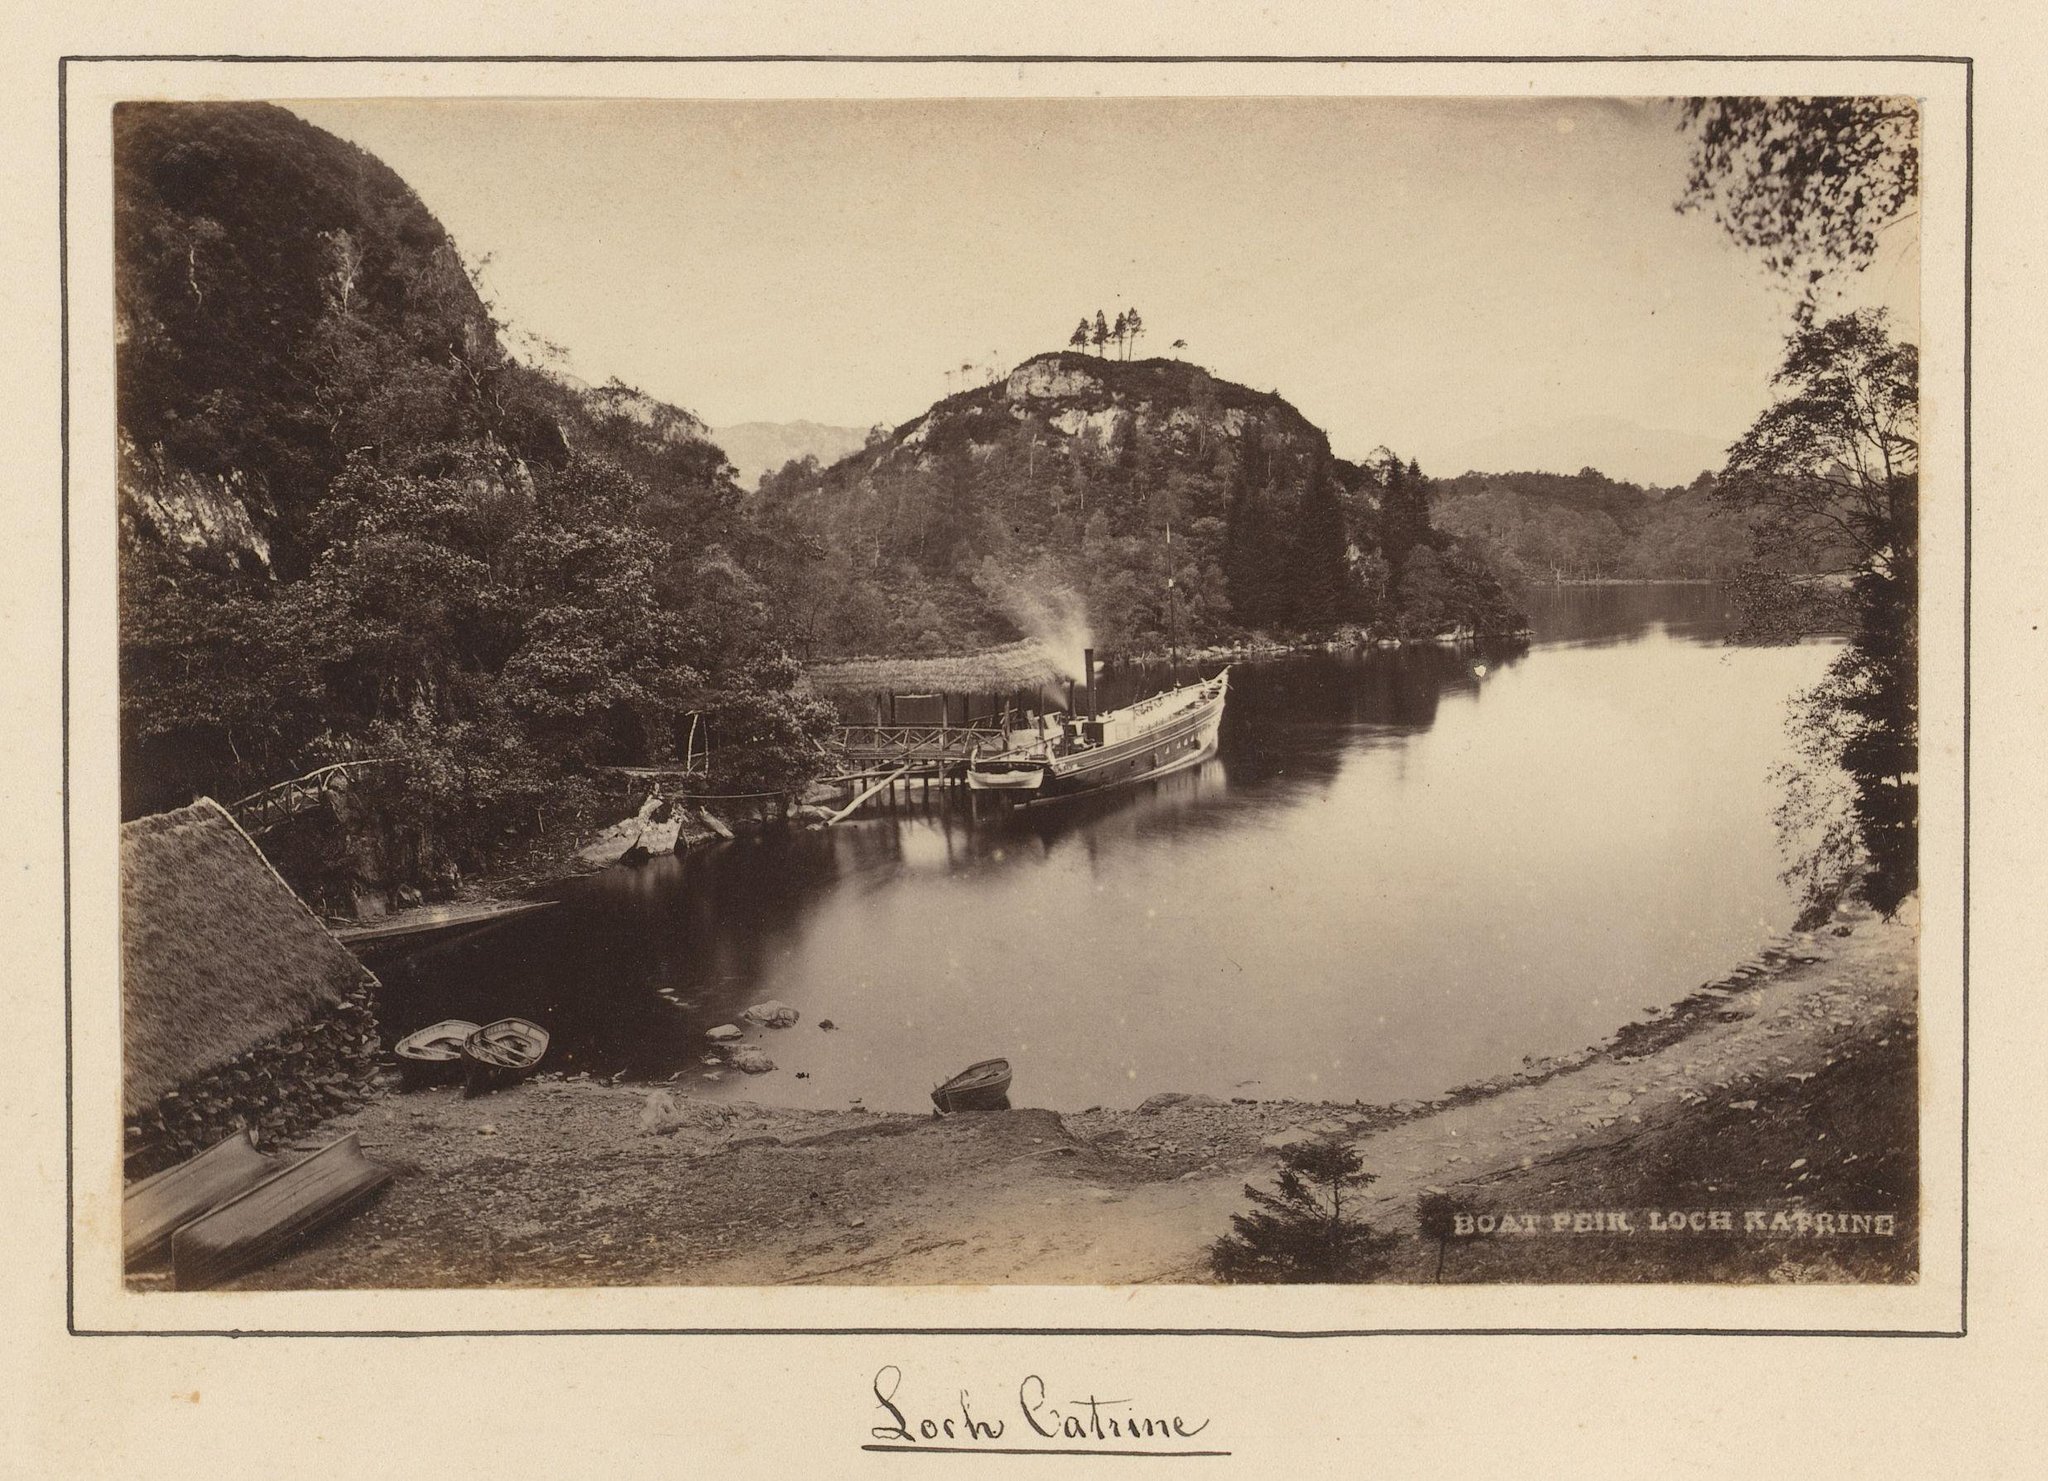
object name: album leaf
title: Stoomschip op Loch Katrine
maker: Anonymous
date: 1870-1890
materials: paper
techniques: albumen print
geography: loch katrine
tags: lake, steamship, motorship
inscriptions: inscription: ‘Boat Peir, Loch Katrine’